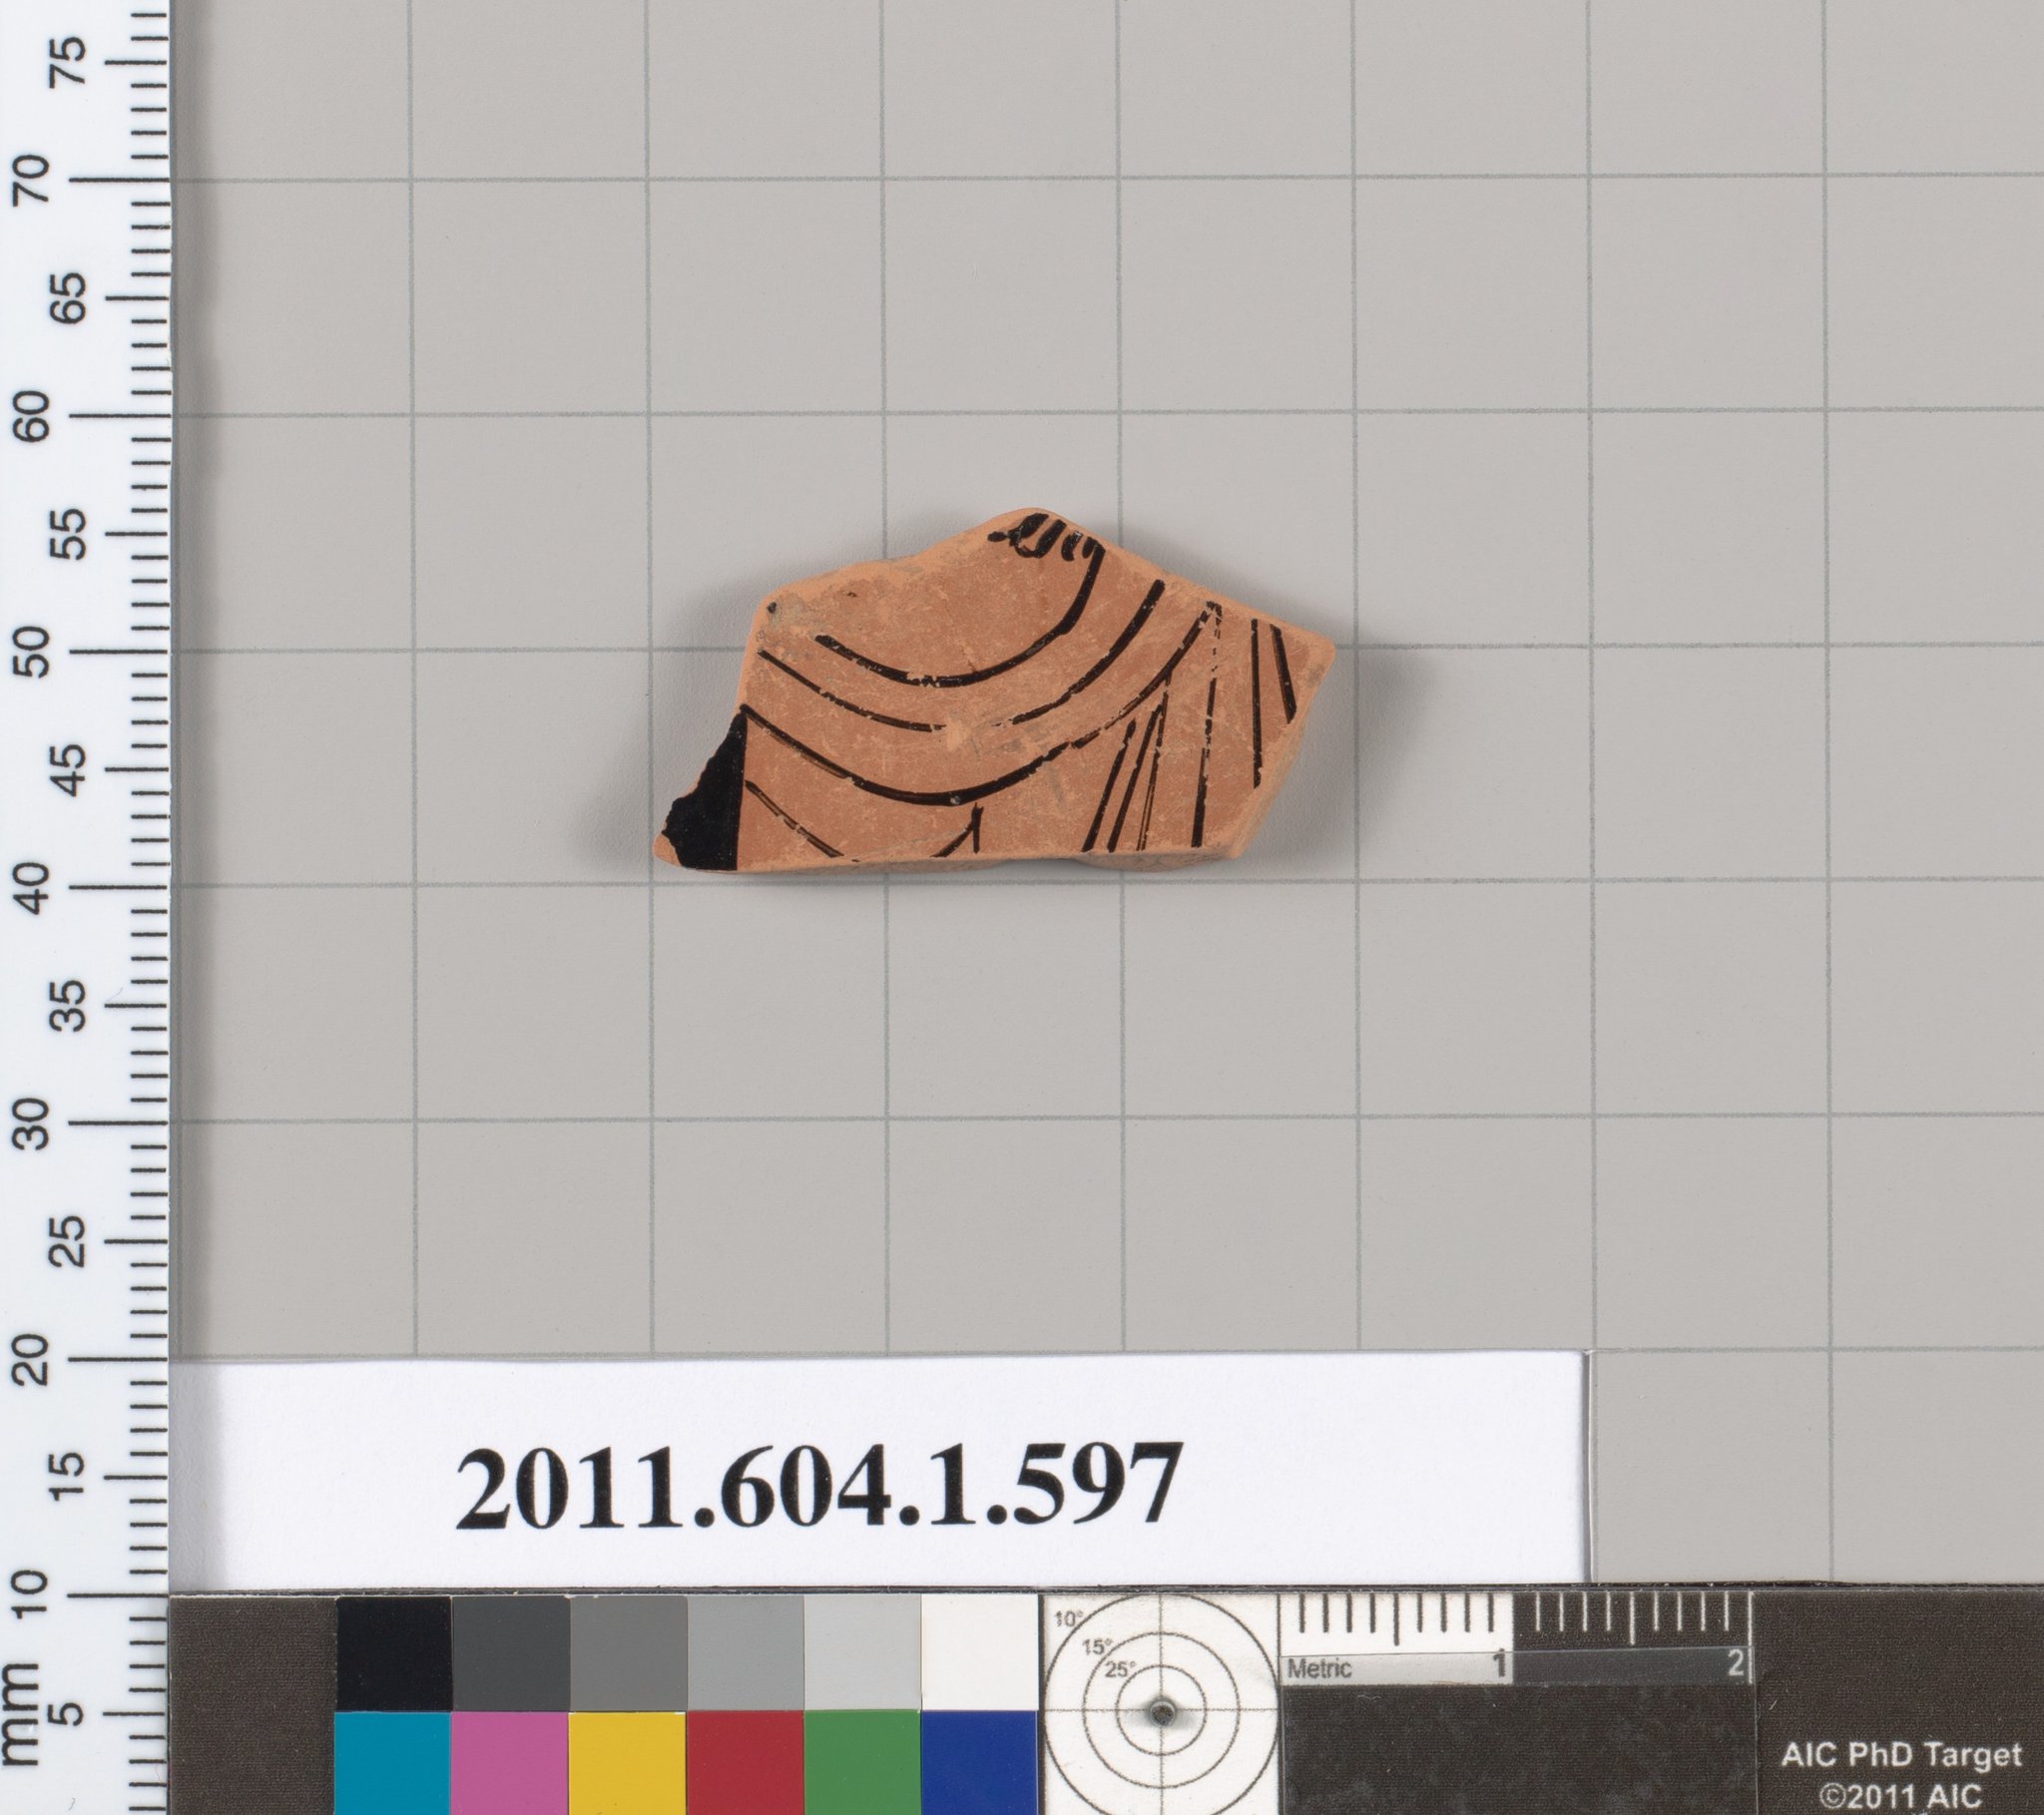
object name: kylix fragment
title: Terracotta fragment of a kylix (drinking cup)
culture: greek, attic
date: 475-451 BCE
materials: terracotta